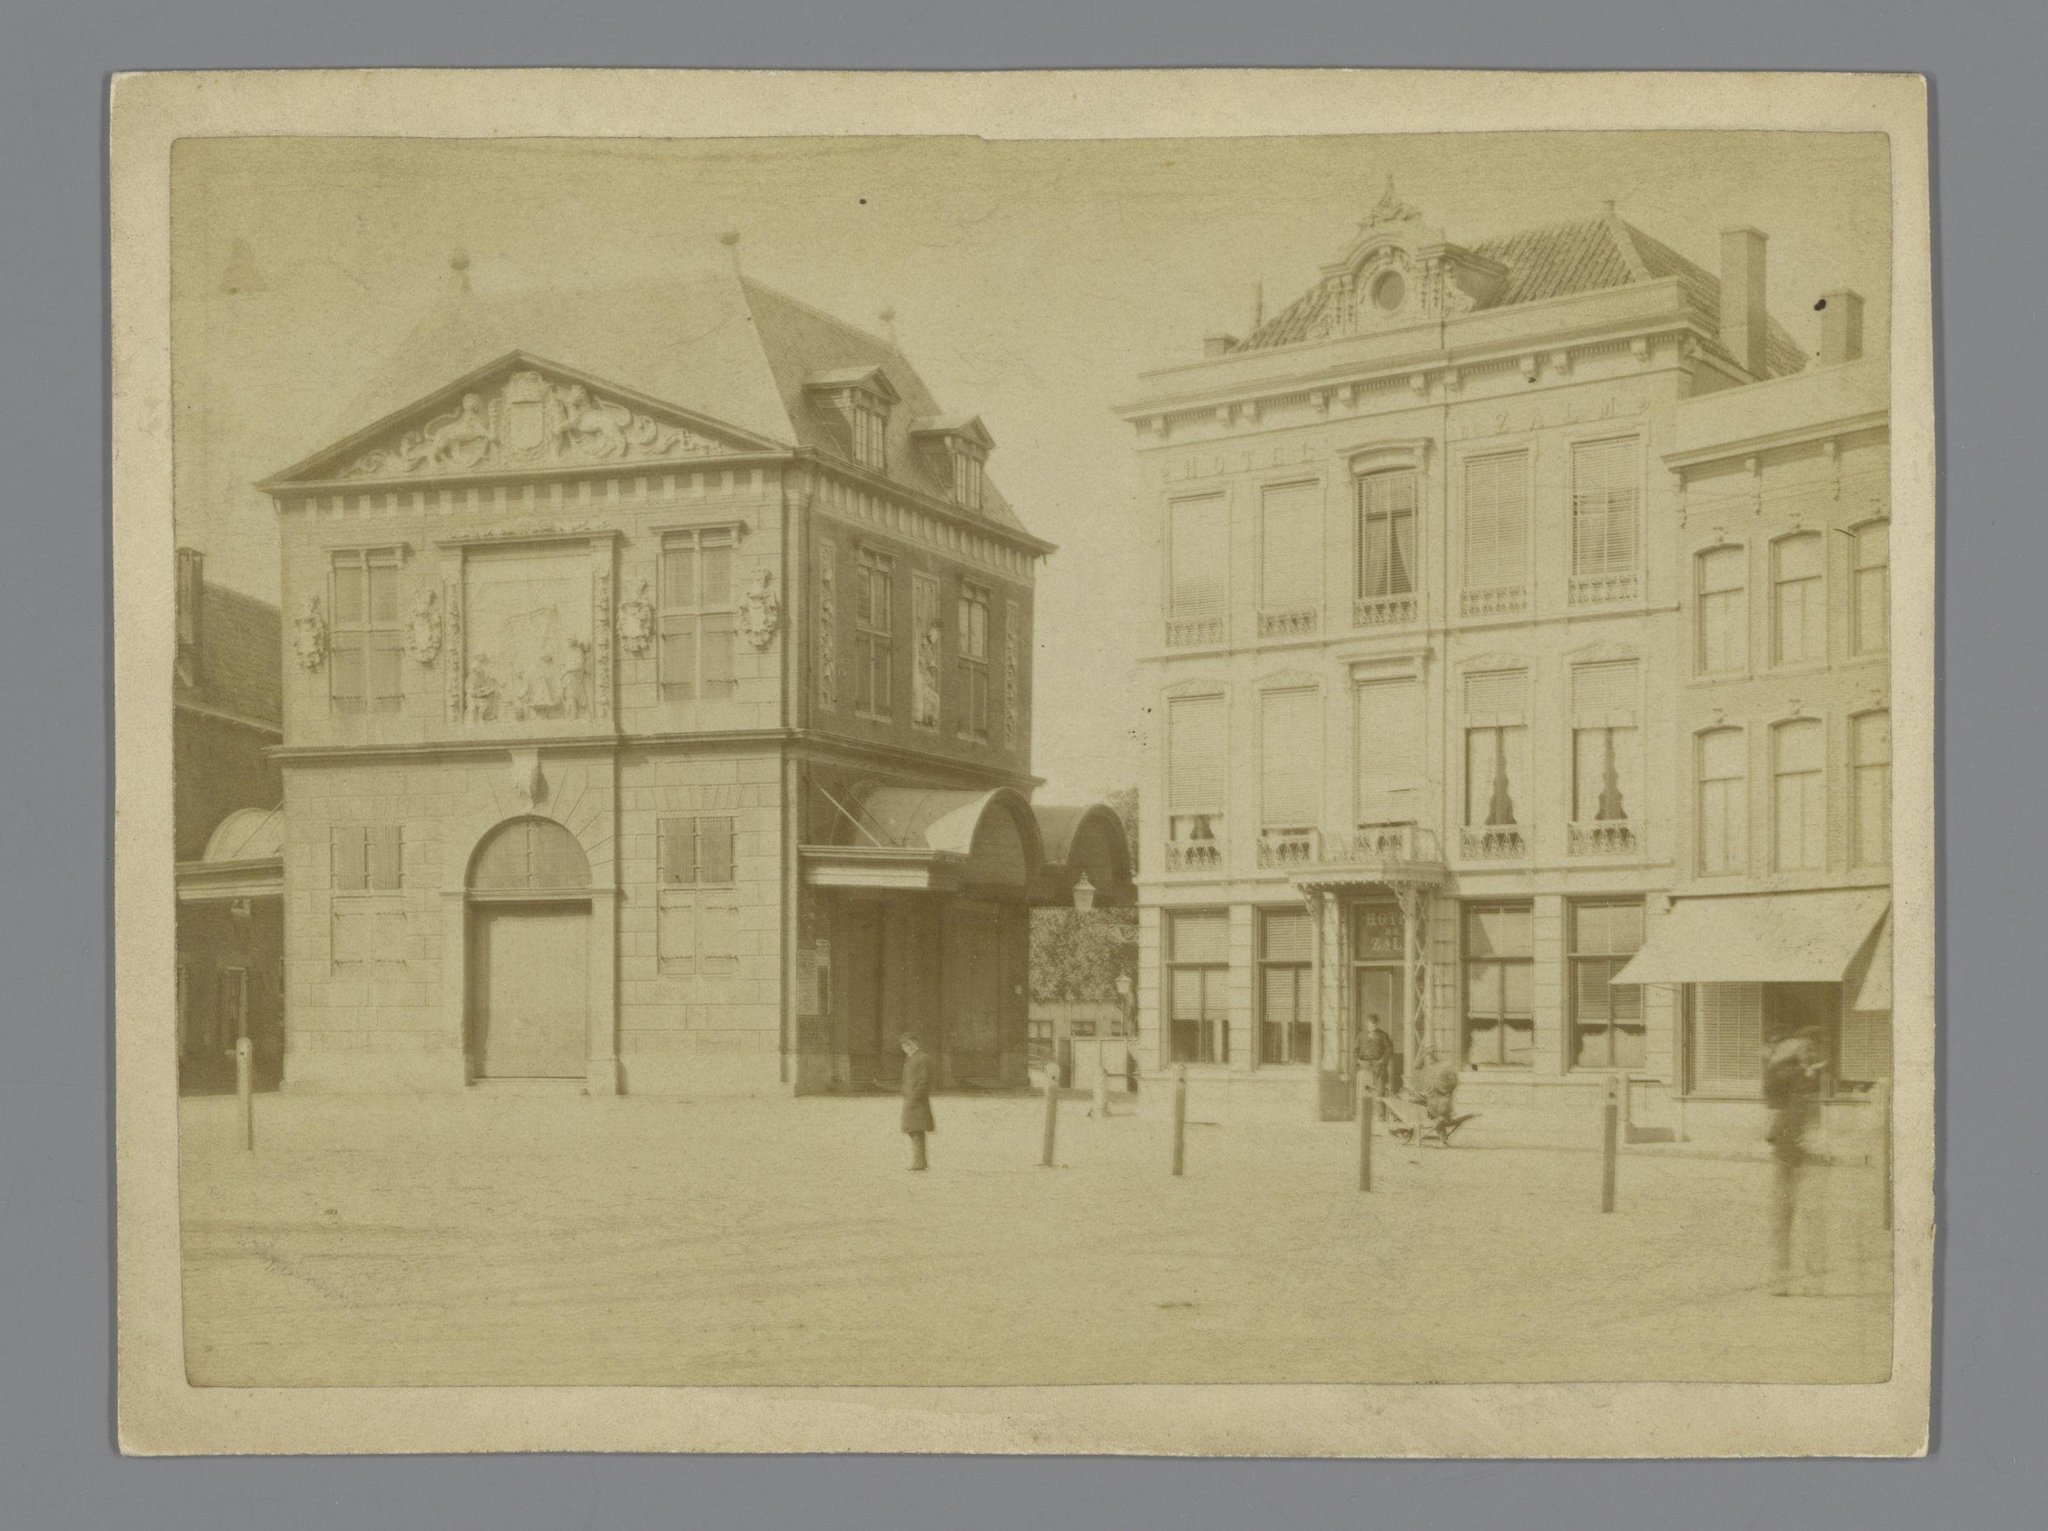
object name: photograph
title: Gezicht op de Waag te Gouda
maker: Anonymous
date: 1860-1900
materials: cardboard, photographic support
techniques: albumen print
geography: gouda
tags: weigh-house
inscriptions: annotation: ‘Gouda!’